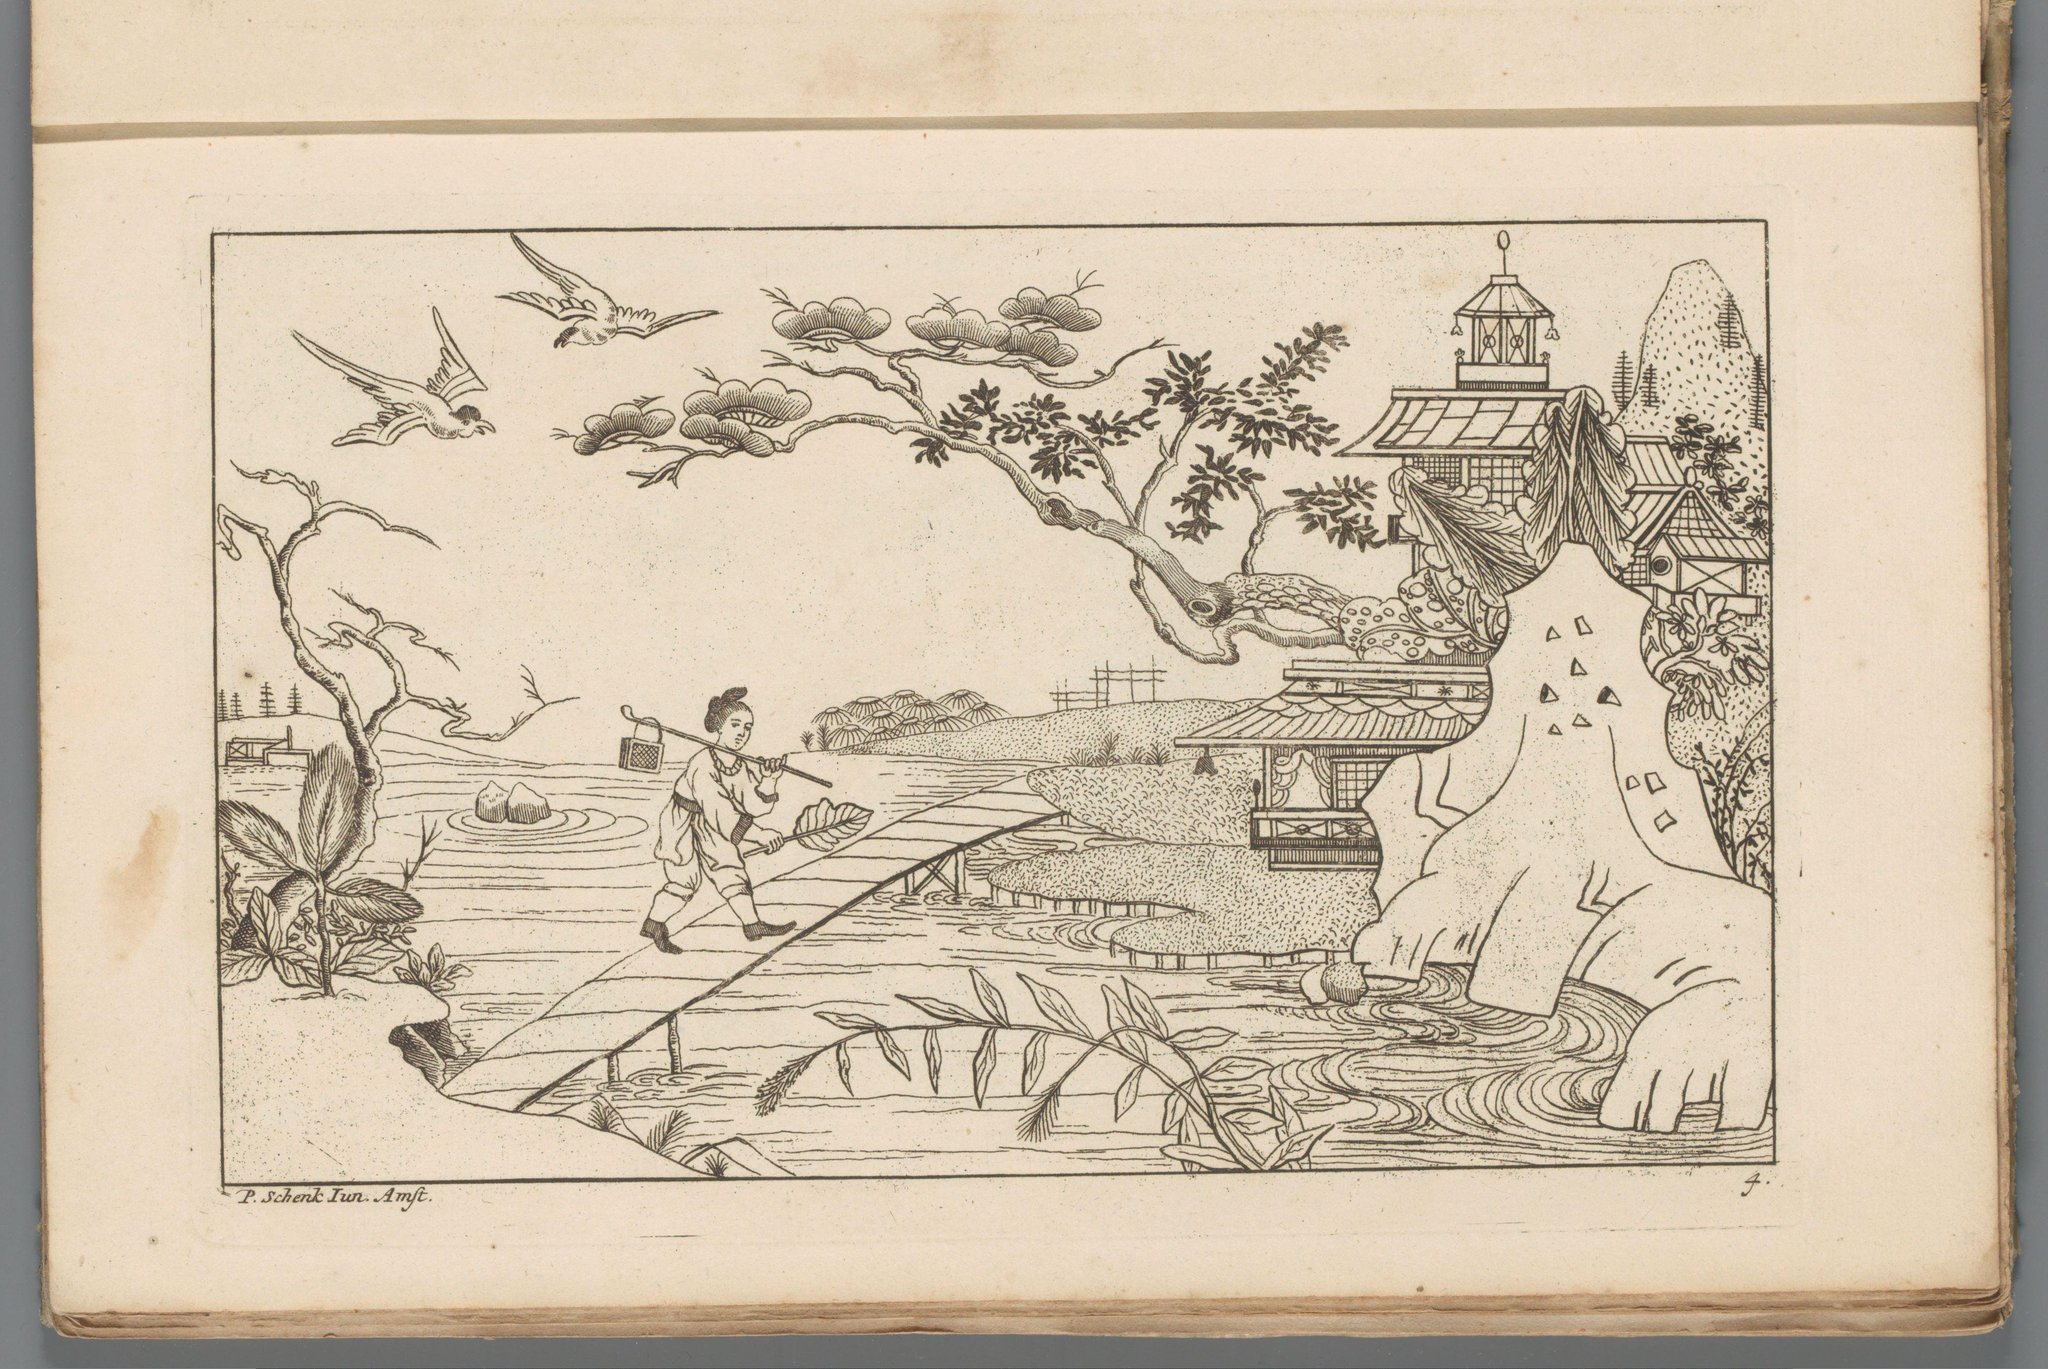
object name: ornament print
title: Chinese figuur op brug over rivier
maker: pieter schenk (ii)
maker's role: draughtsman, print maker, publisher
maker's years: 1693-1775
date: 1727-1775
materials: paper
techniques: etching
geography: amsterdam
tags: chinese (+ women), water course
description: Een Chinese figuur loopt met een koffer aan een stok over de schouder en met een blad in de hand over een brug over een rivier. Rechts op de oever gebouwen. Prent maakt deel uit van een album.